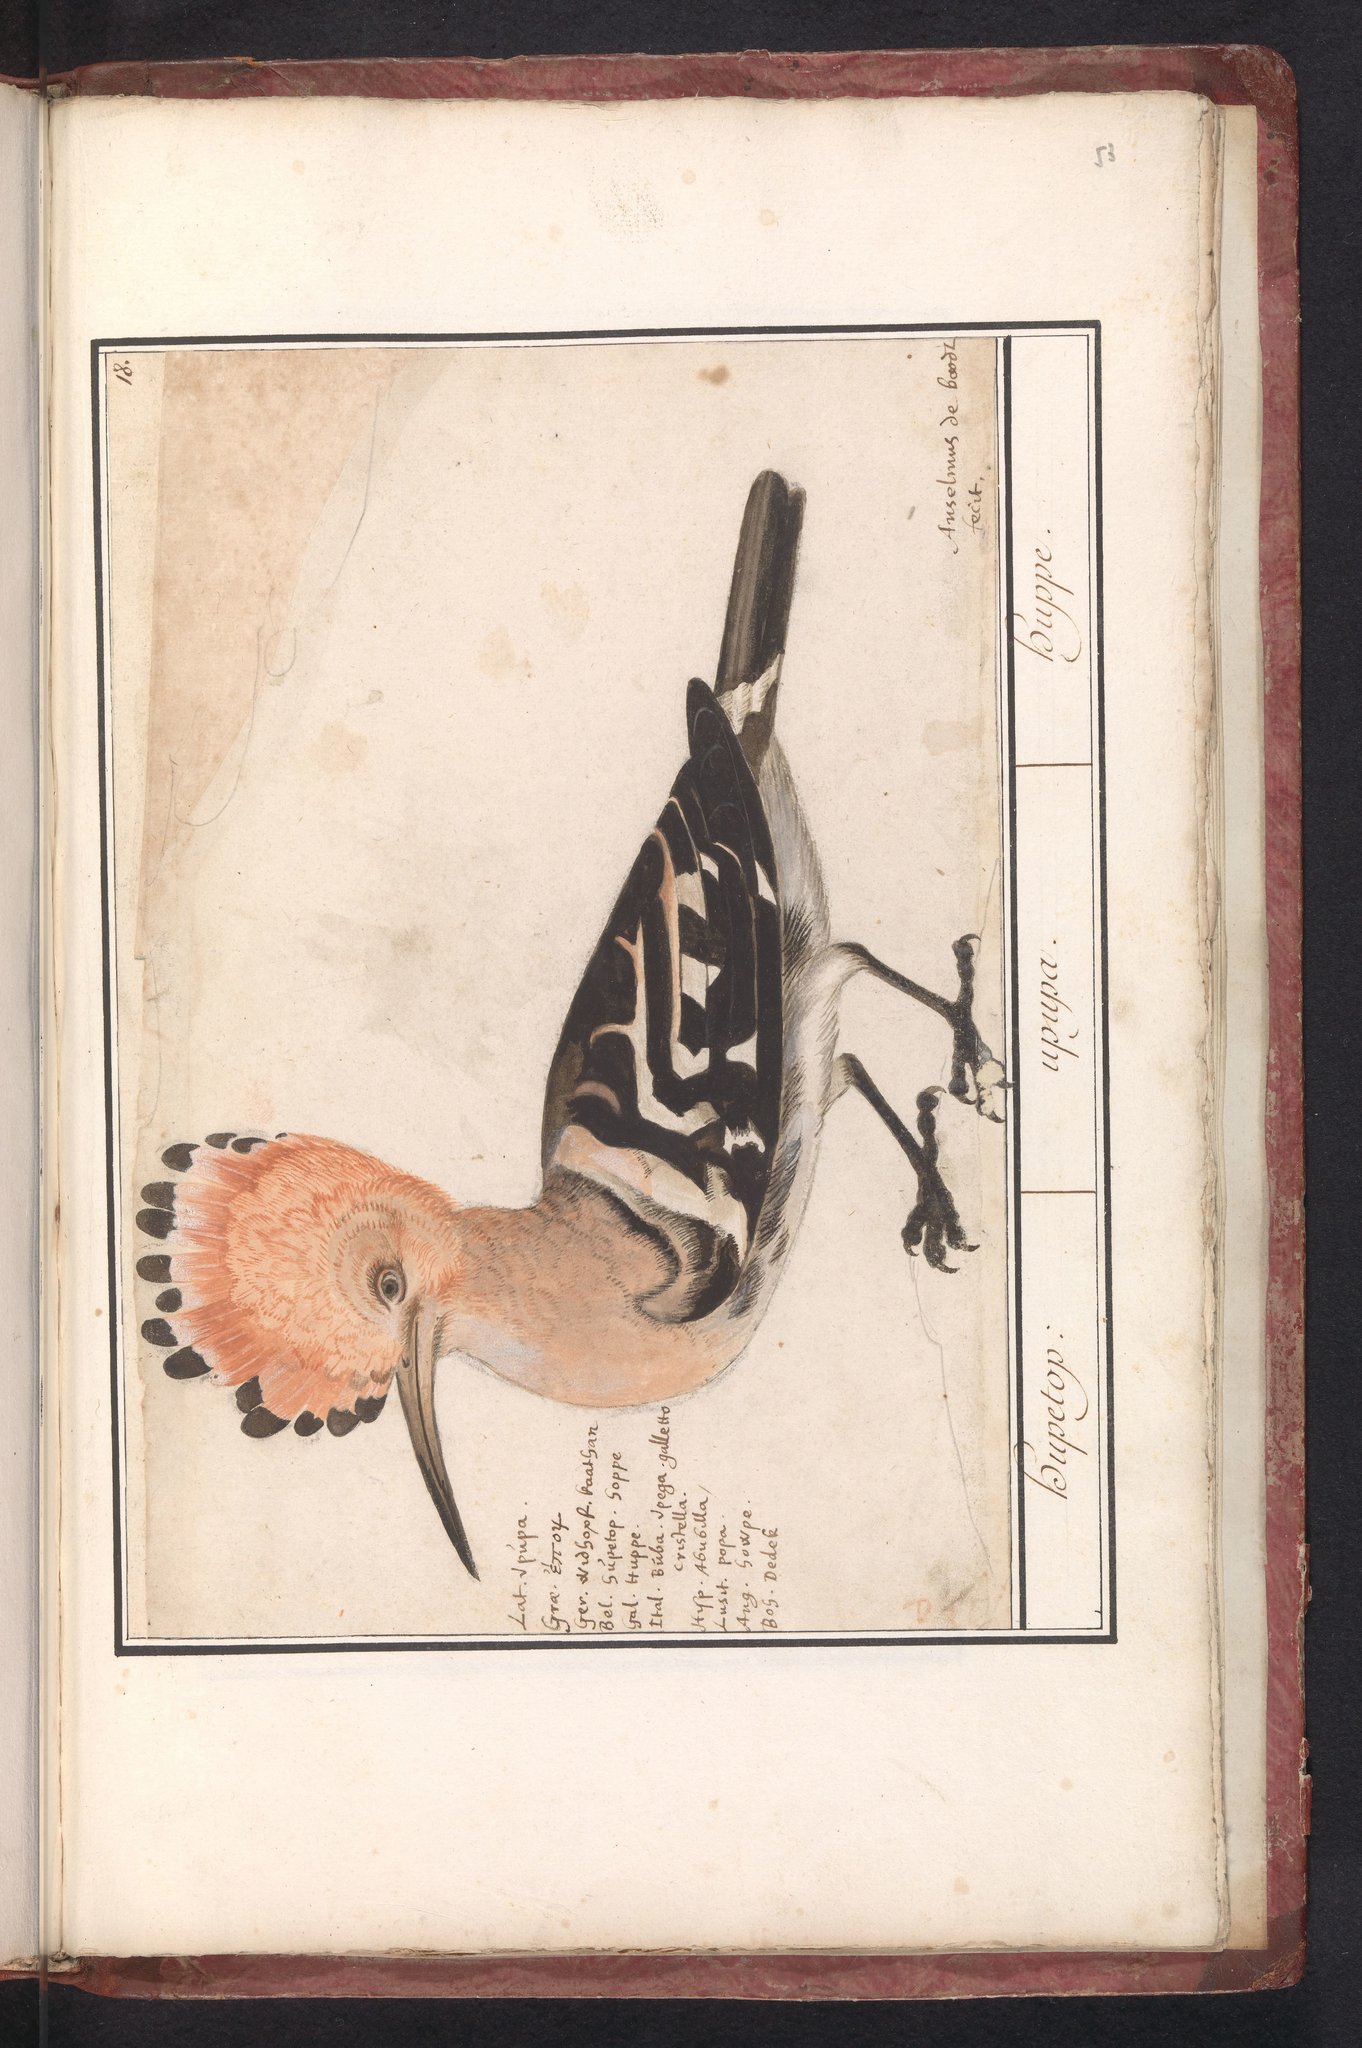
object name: drawing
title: Hoopoe (Upupa epops)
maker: anselmus boëtius de boodt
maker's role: draughtsman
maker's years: 1550-1632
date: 1596-1610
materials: chalk, paint, ink, paper, pencil, watercolor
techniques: brush, pen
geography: prague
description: De Boodt probably assembled his ‘three large books’ as followed: one for plants, one for animals and one for birds. The latter was apparently damaged (many of the bird studies have a loss at one corner), which may have prompted the 18th-century remounting campaign. Here the upper right corner is missing, but the hoopoe remained unaffected. Its black-tipped crest – which opens only when excited – can be seen in all its glory.